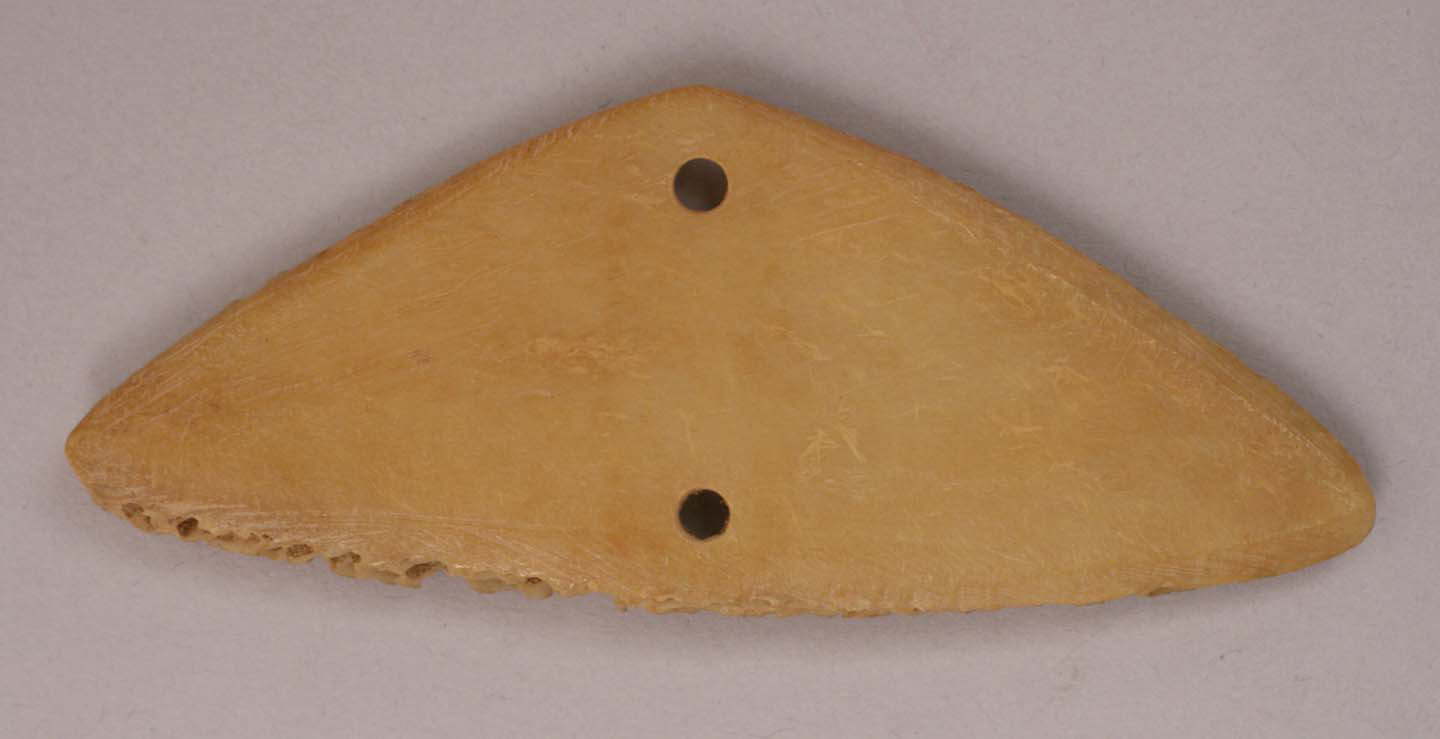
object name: plaque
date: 401-800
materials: bone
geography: palestine